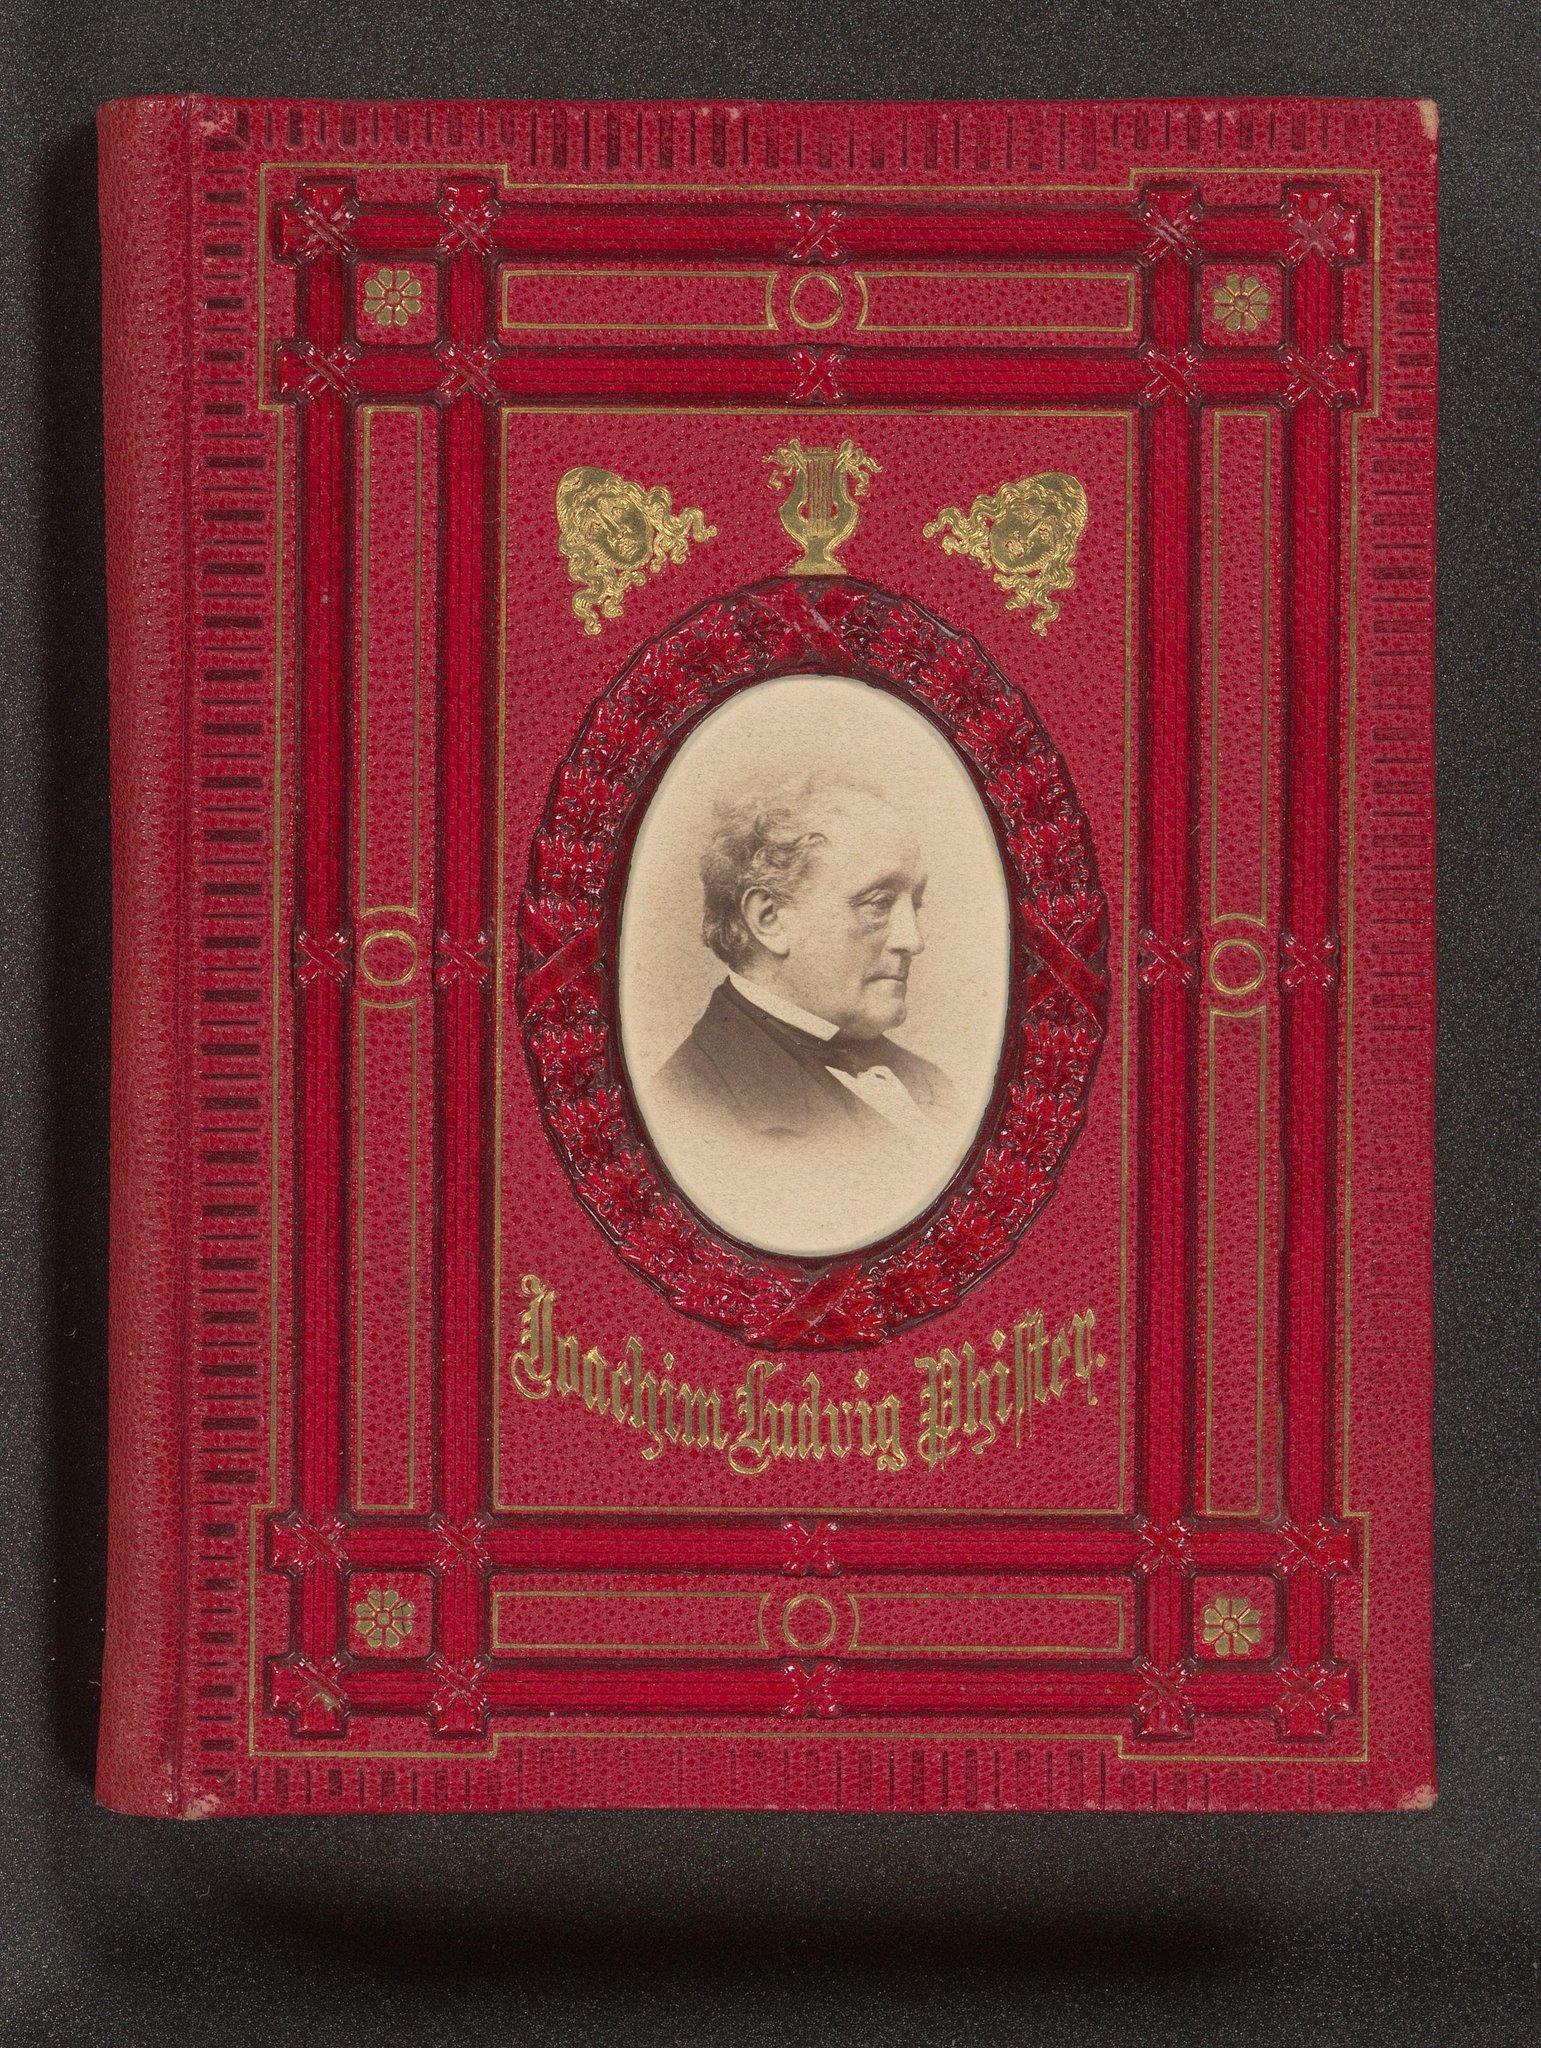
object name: page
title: Joachim Ludvig Phister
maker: harald paetz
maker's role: fotograaf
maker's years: 1837-1895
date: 1862-1872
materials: photographic support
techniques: albumen print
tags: portrait of actor, actress